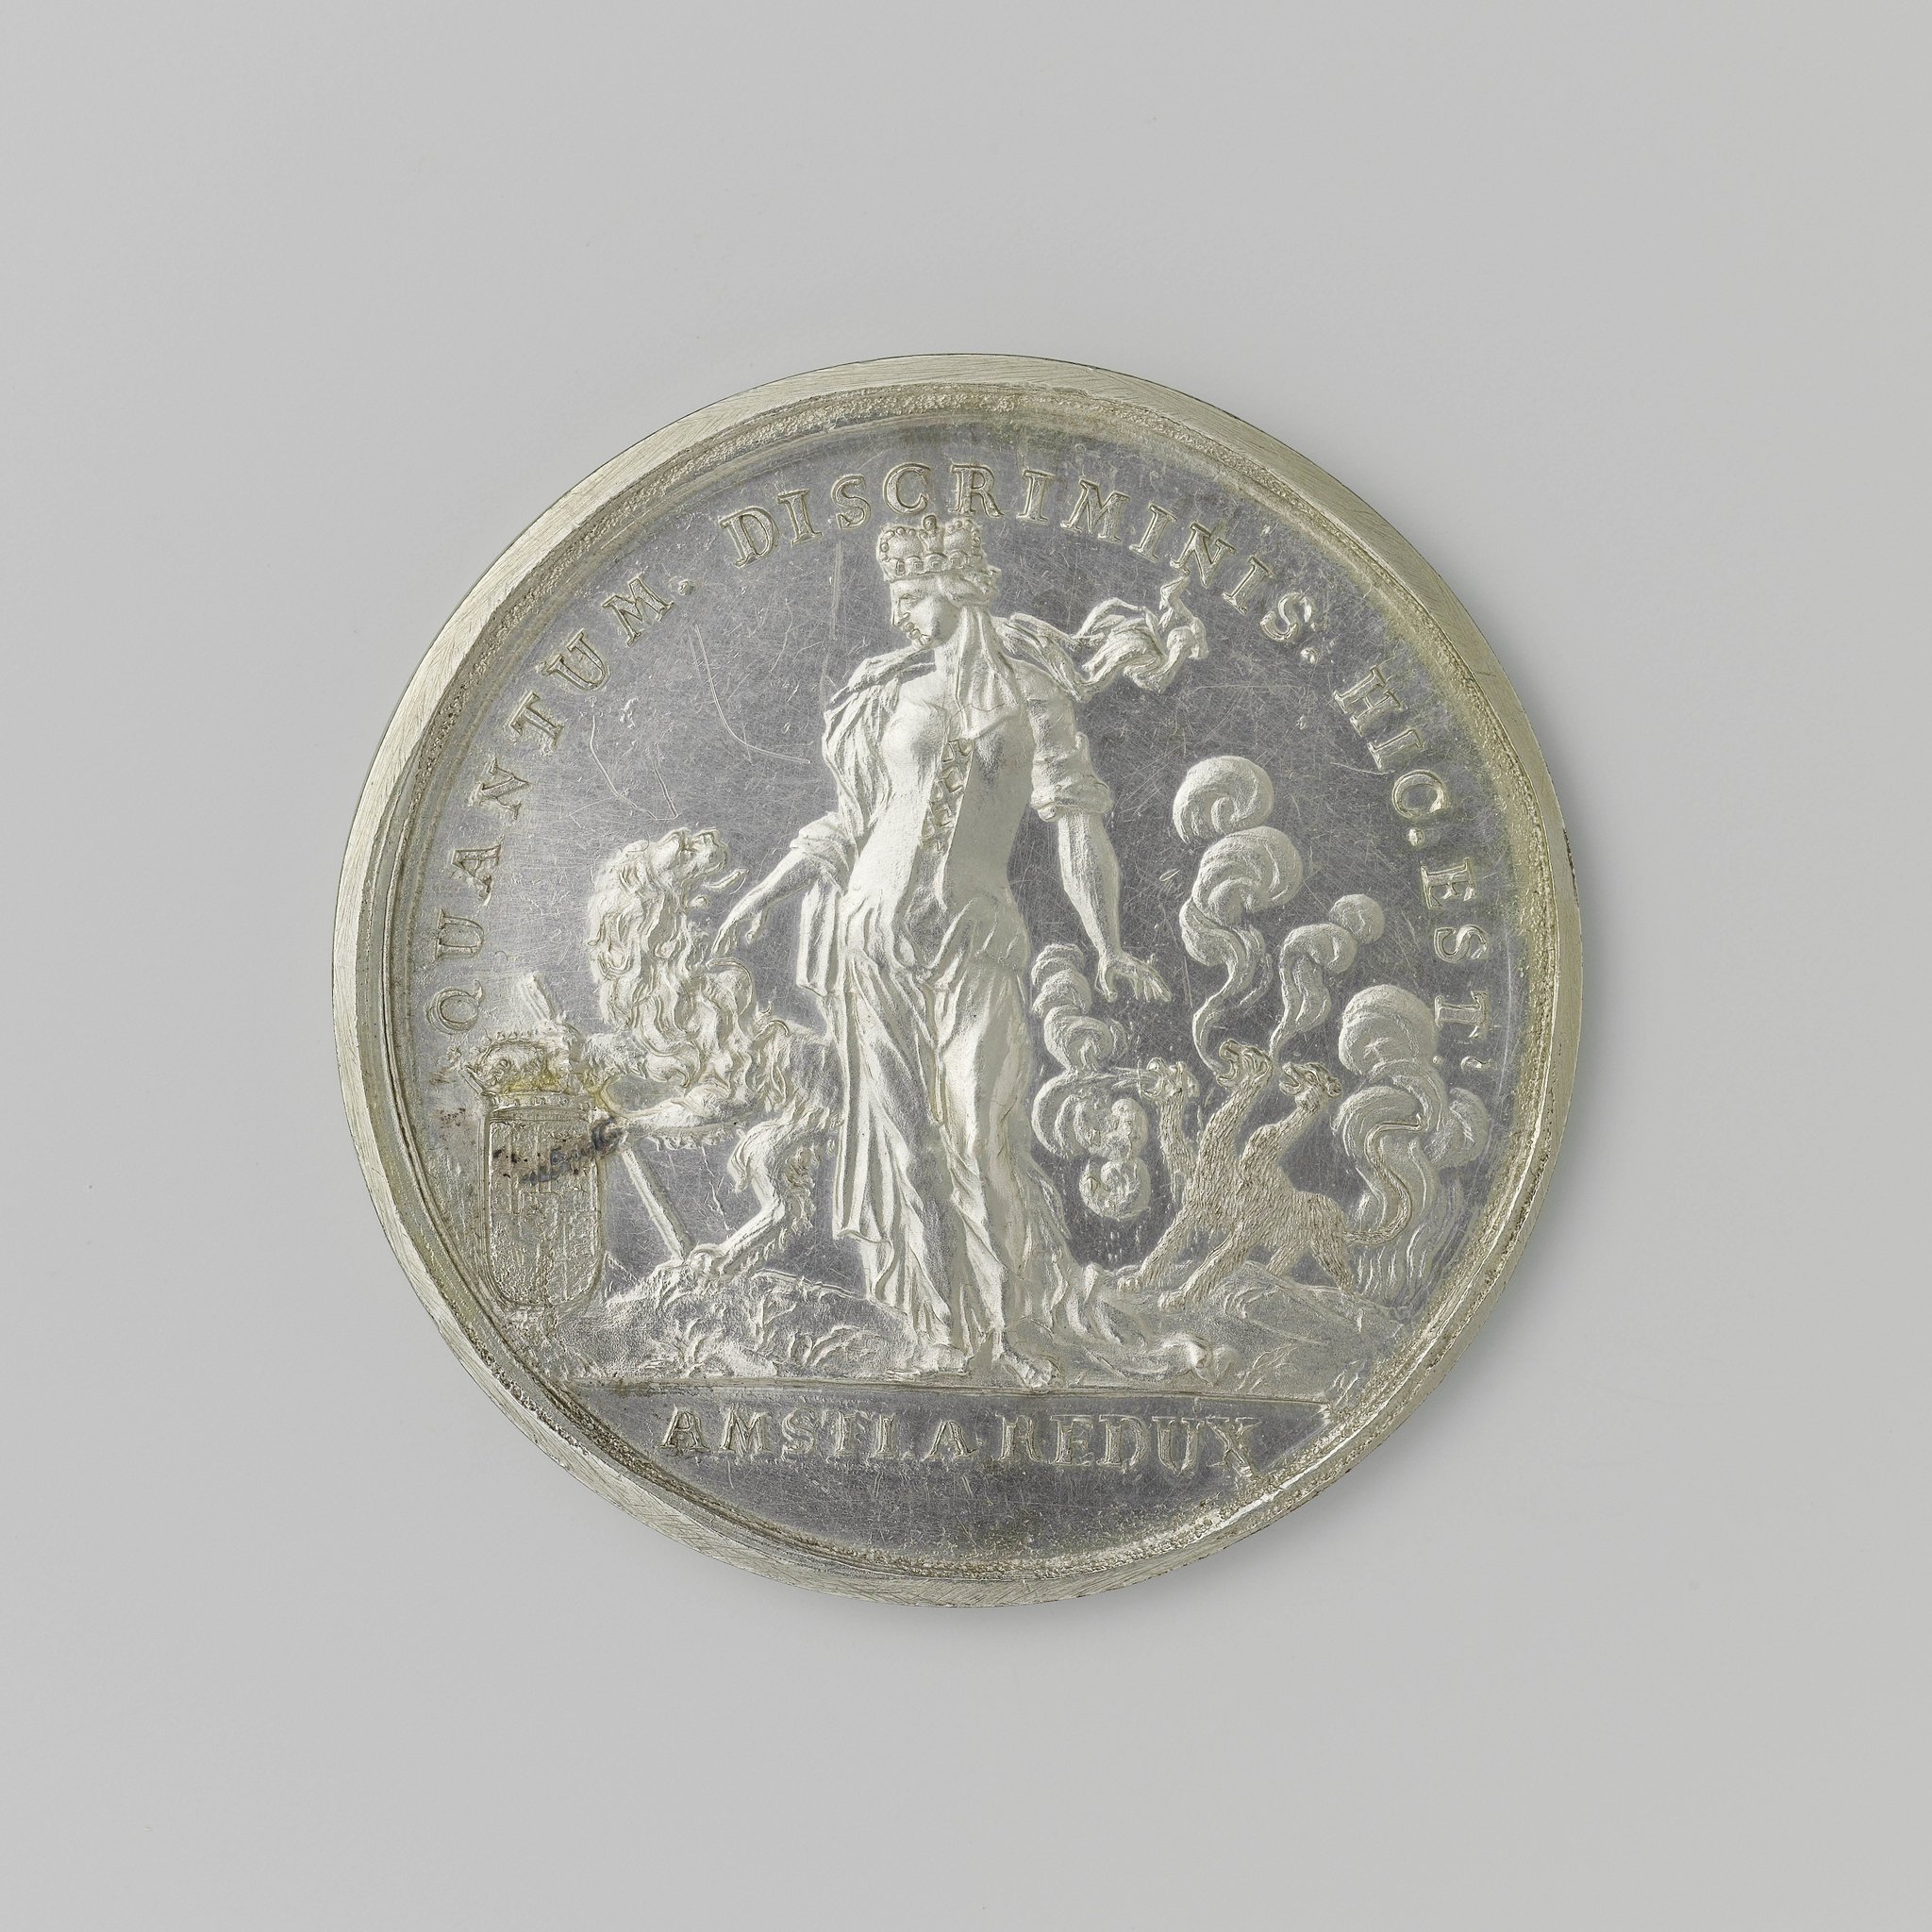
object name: history medal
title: Beëindiging van de geschillen tussen Amsterdam en Willem III en diens aanstaande overtocht naar Ierland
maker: Anonymous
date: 1690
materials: silver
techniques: striking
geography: netherlands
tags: the hague, william iii (prince of orange and king of england, scotland, and ireland), amsterdam